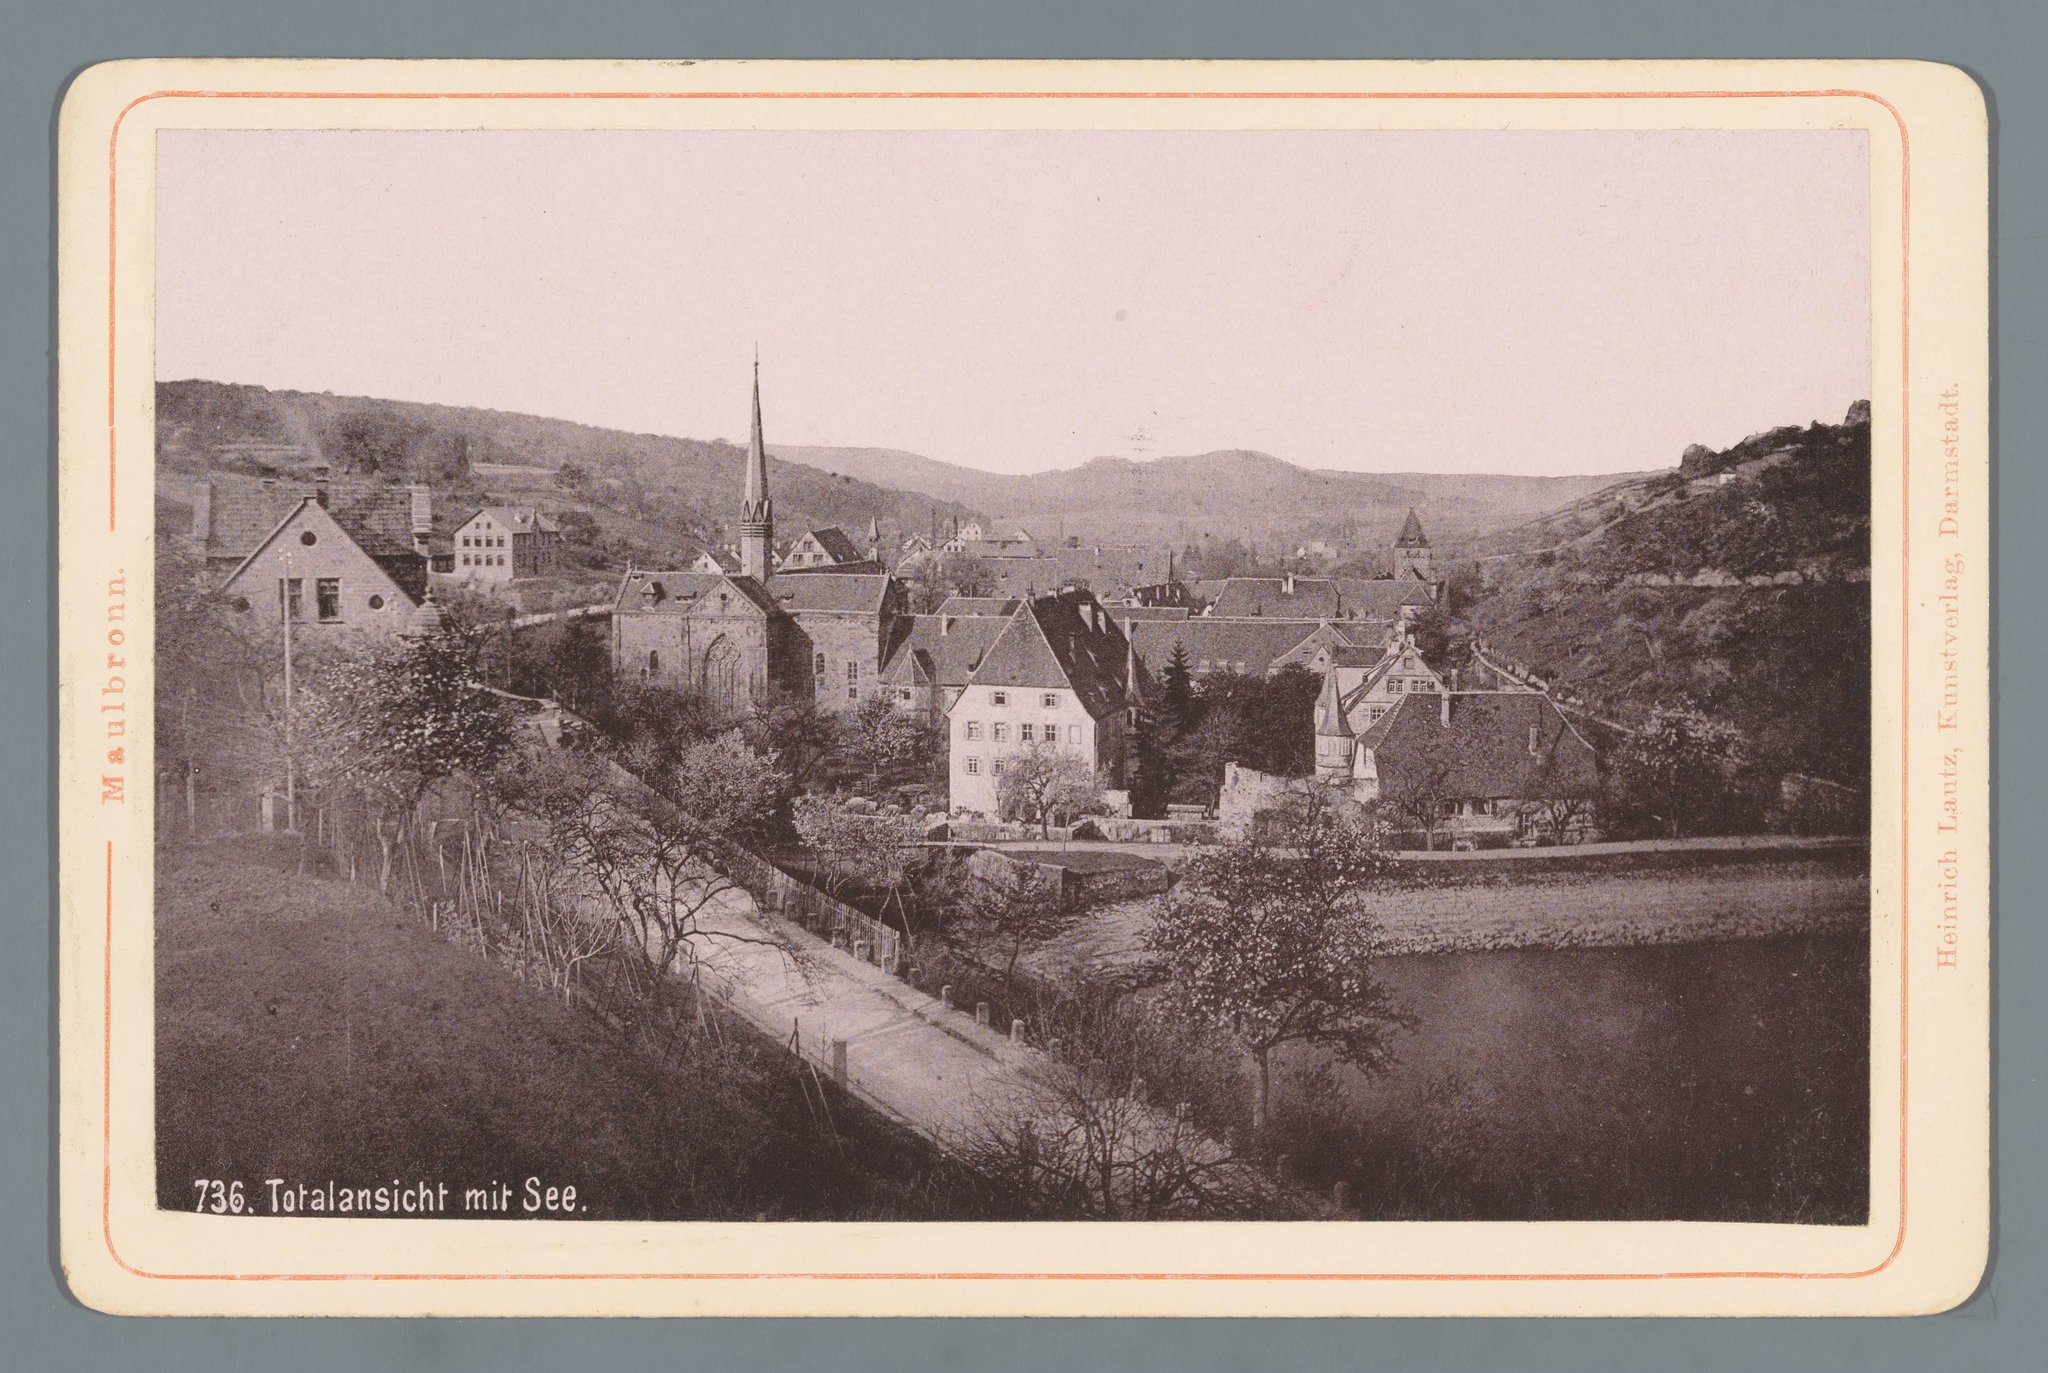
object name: photomechanical print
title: Totalansicht mit See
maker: Anonymous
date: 1895-1900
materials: cardboard, paper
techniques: photograph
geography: darmstadt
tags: city-view in general; 'veduta'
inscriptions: number: ‘736’, inscription: ‘17 Juli 1894.’